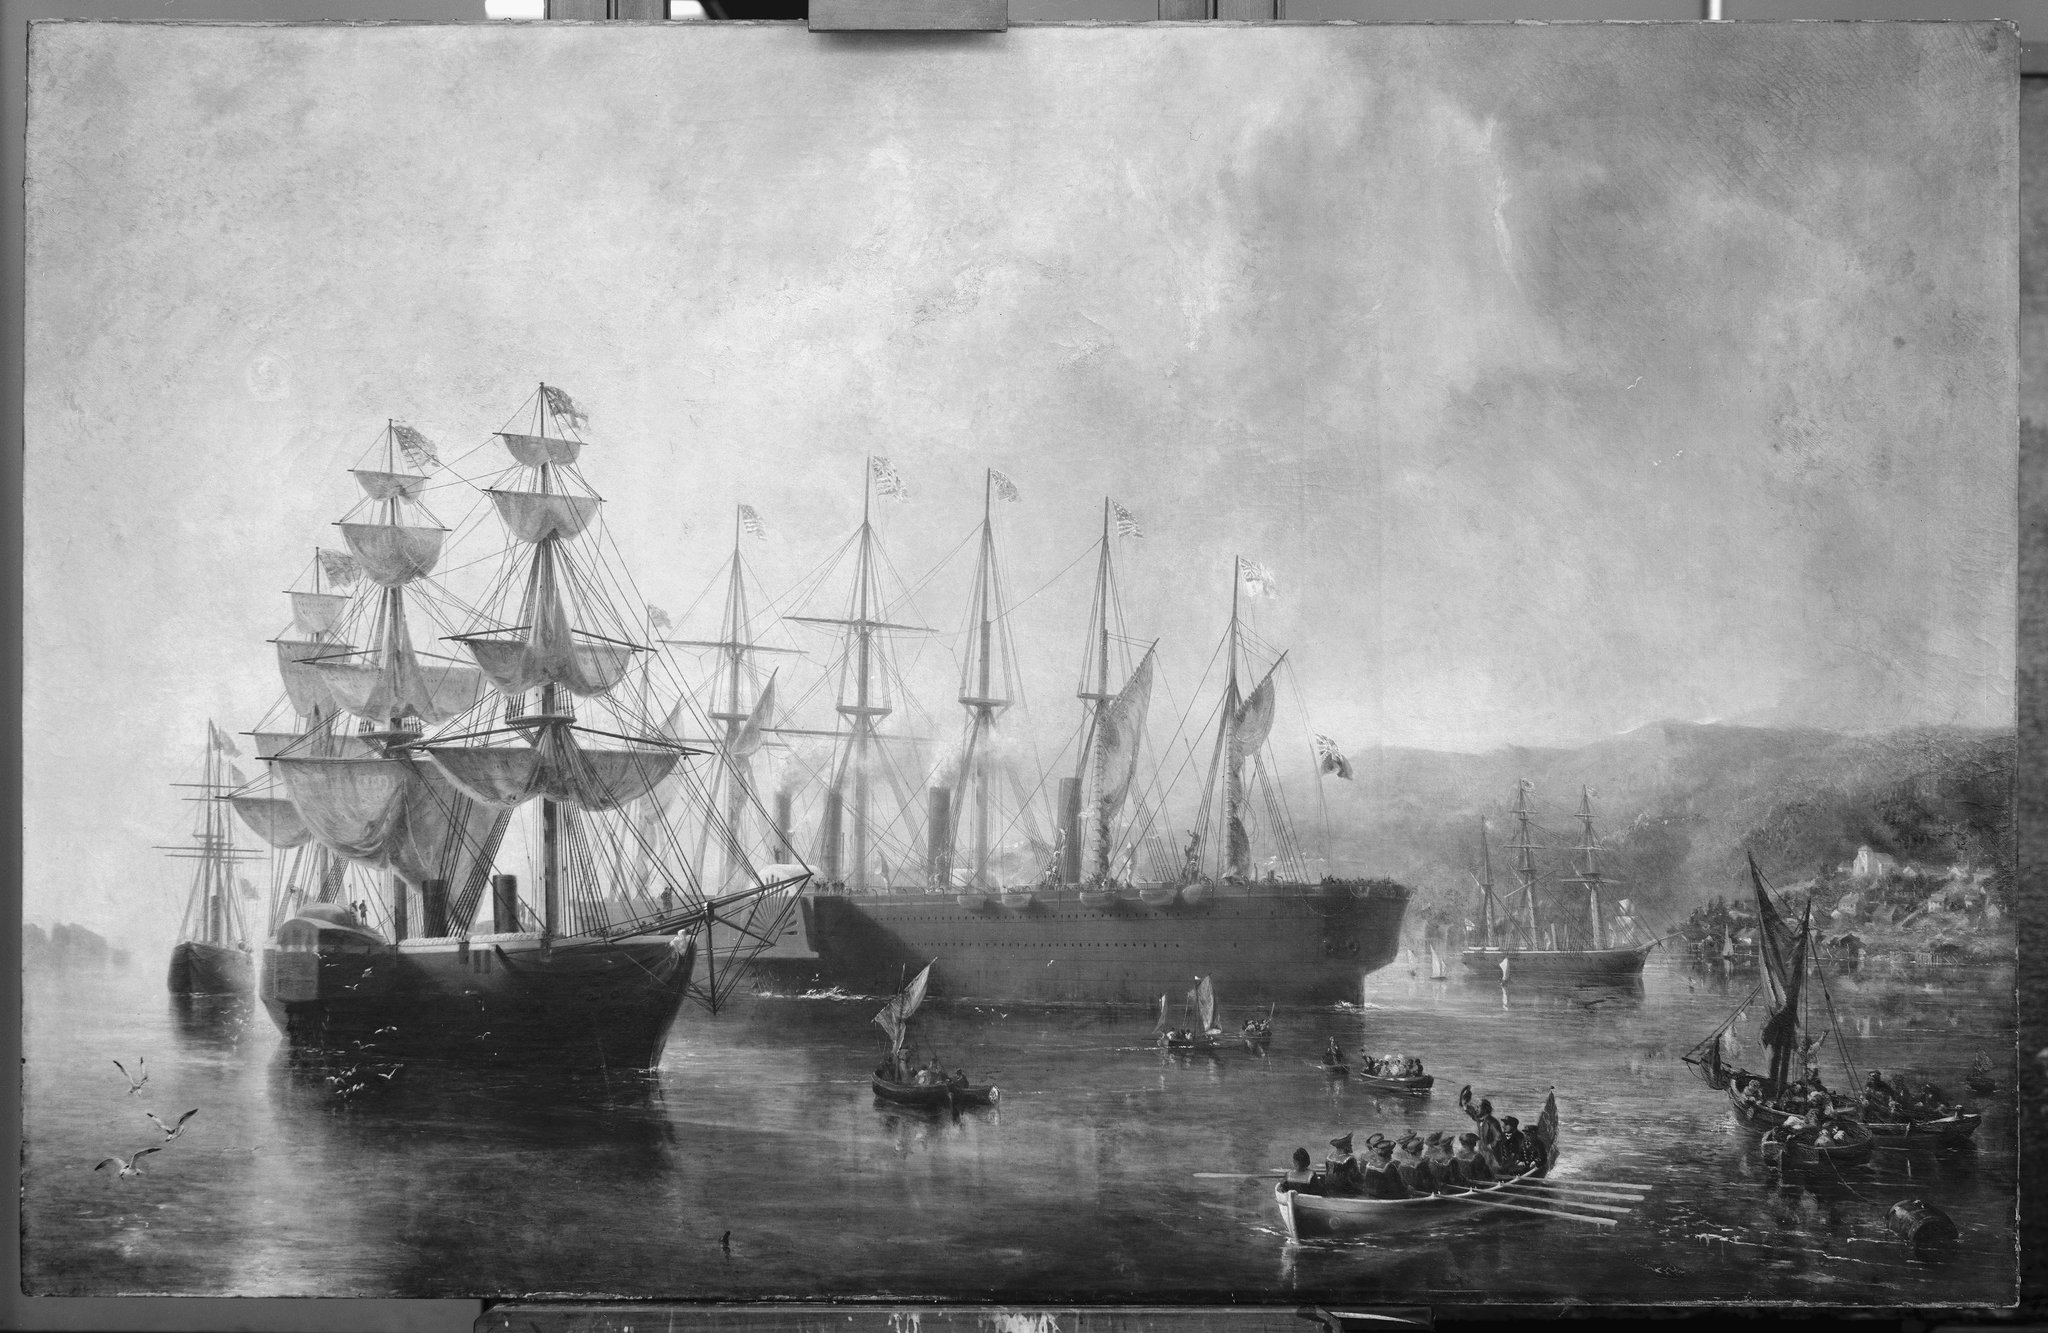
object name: painting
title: Homeward Bound: "The Great Eastern"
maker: robert charles dudley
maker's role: artist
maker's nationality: british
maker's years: 1826-1909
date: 1866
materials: canvas, oil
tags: boats,ships,transatlantic cable